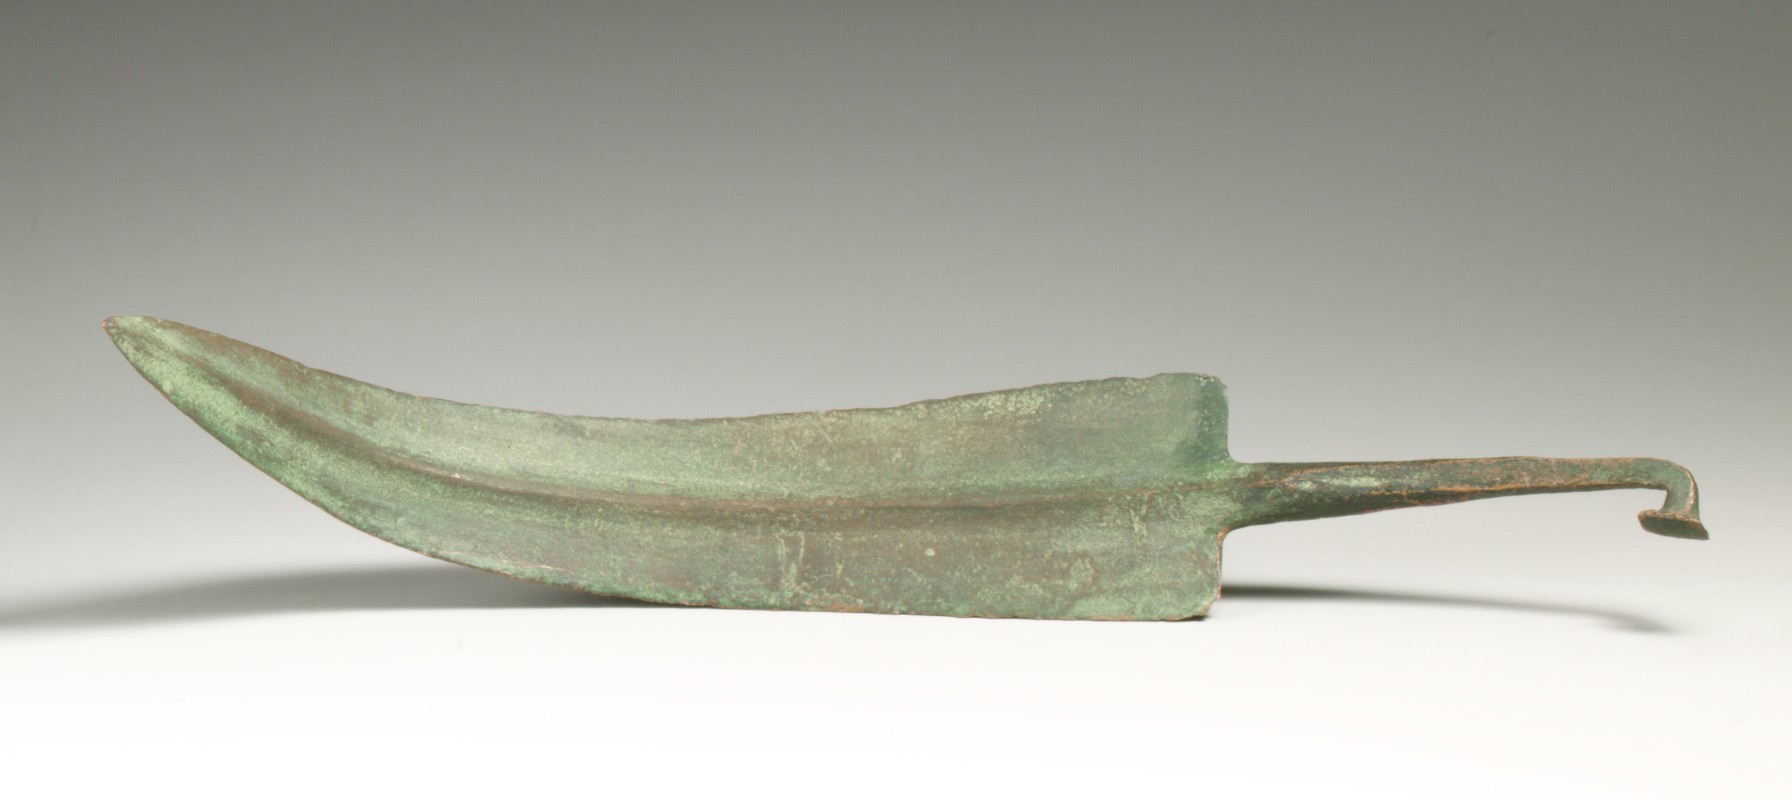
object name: spearhead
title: Bronze spearhead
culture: cypriot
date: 2000-1900 BCE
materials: bronze